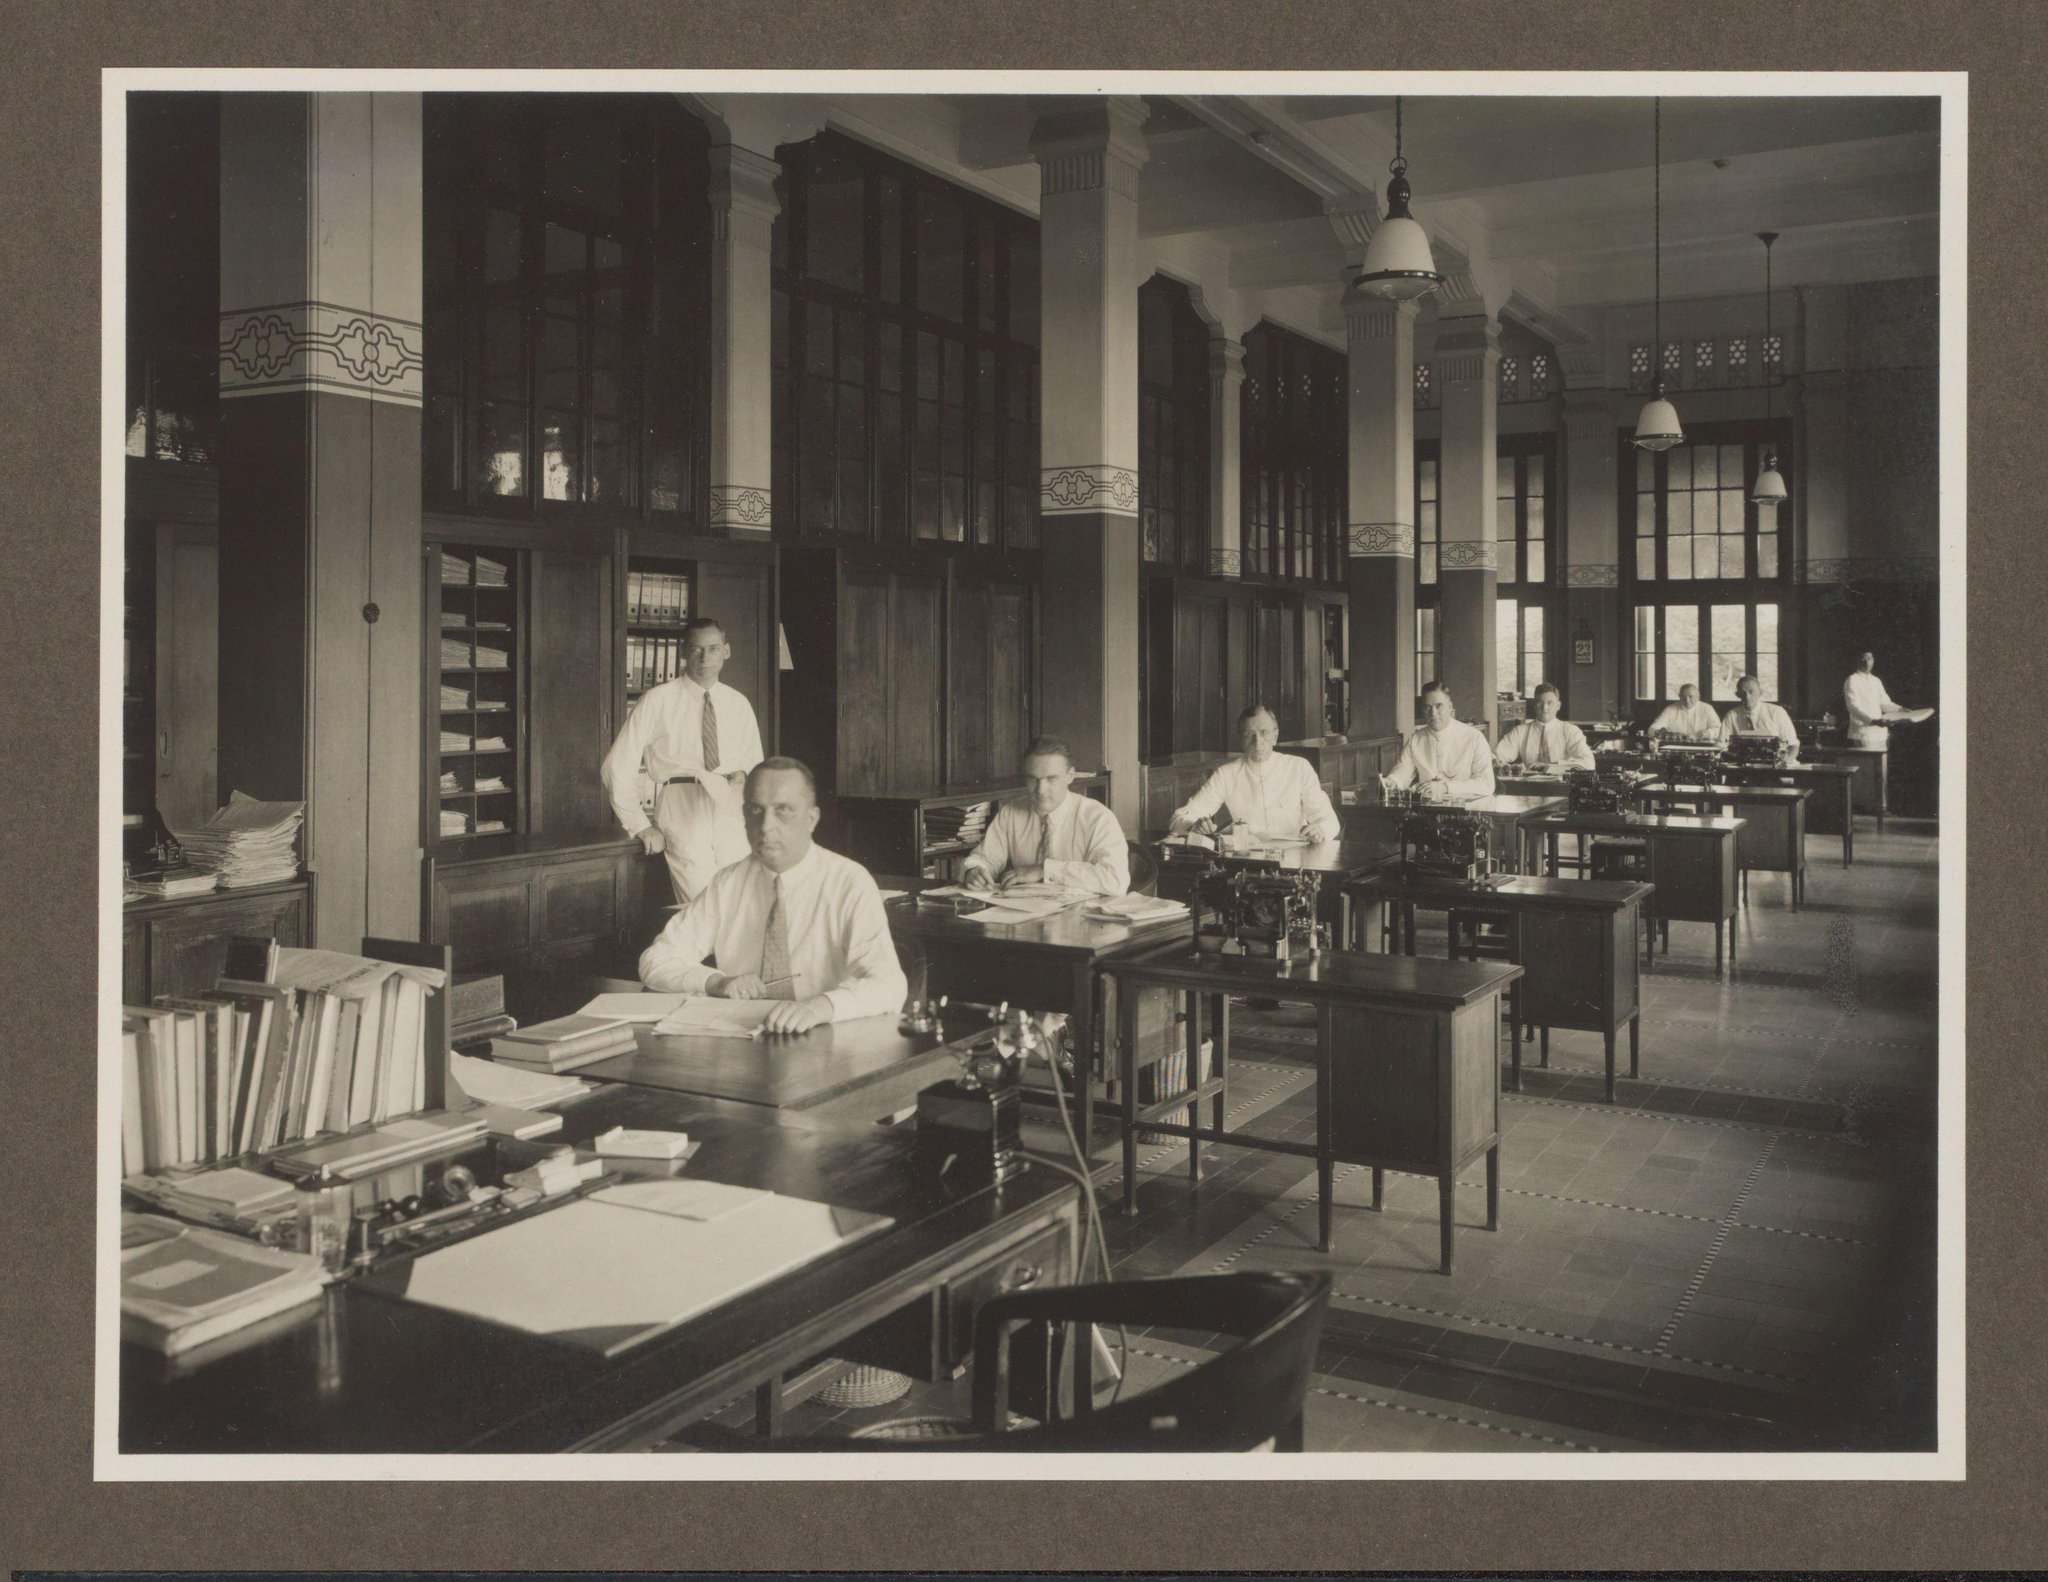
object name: photograph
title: Secretariaat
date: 1904-1931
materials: photographic support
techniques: gelatin silver print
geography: surabaya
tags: colonial system, trade-company, administration ~ trade and finance, surabaya, java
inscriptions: inscription: ‘Secretariaat’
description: Het kantoor van het secretariaat met de werknemers achter hun bureaus. Foto genomen op 23 april 1931. Foto in het het fotoalbum aangeboden aan A. van der Eyk namens de chefs en het personeel van de Handelsvereniging Amsterdam (HVA) te Soerabaja bij zijn vertrek van Java in april 1931.